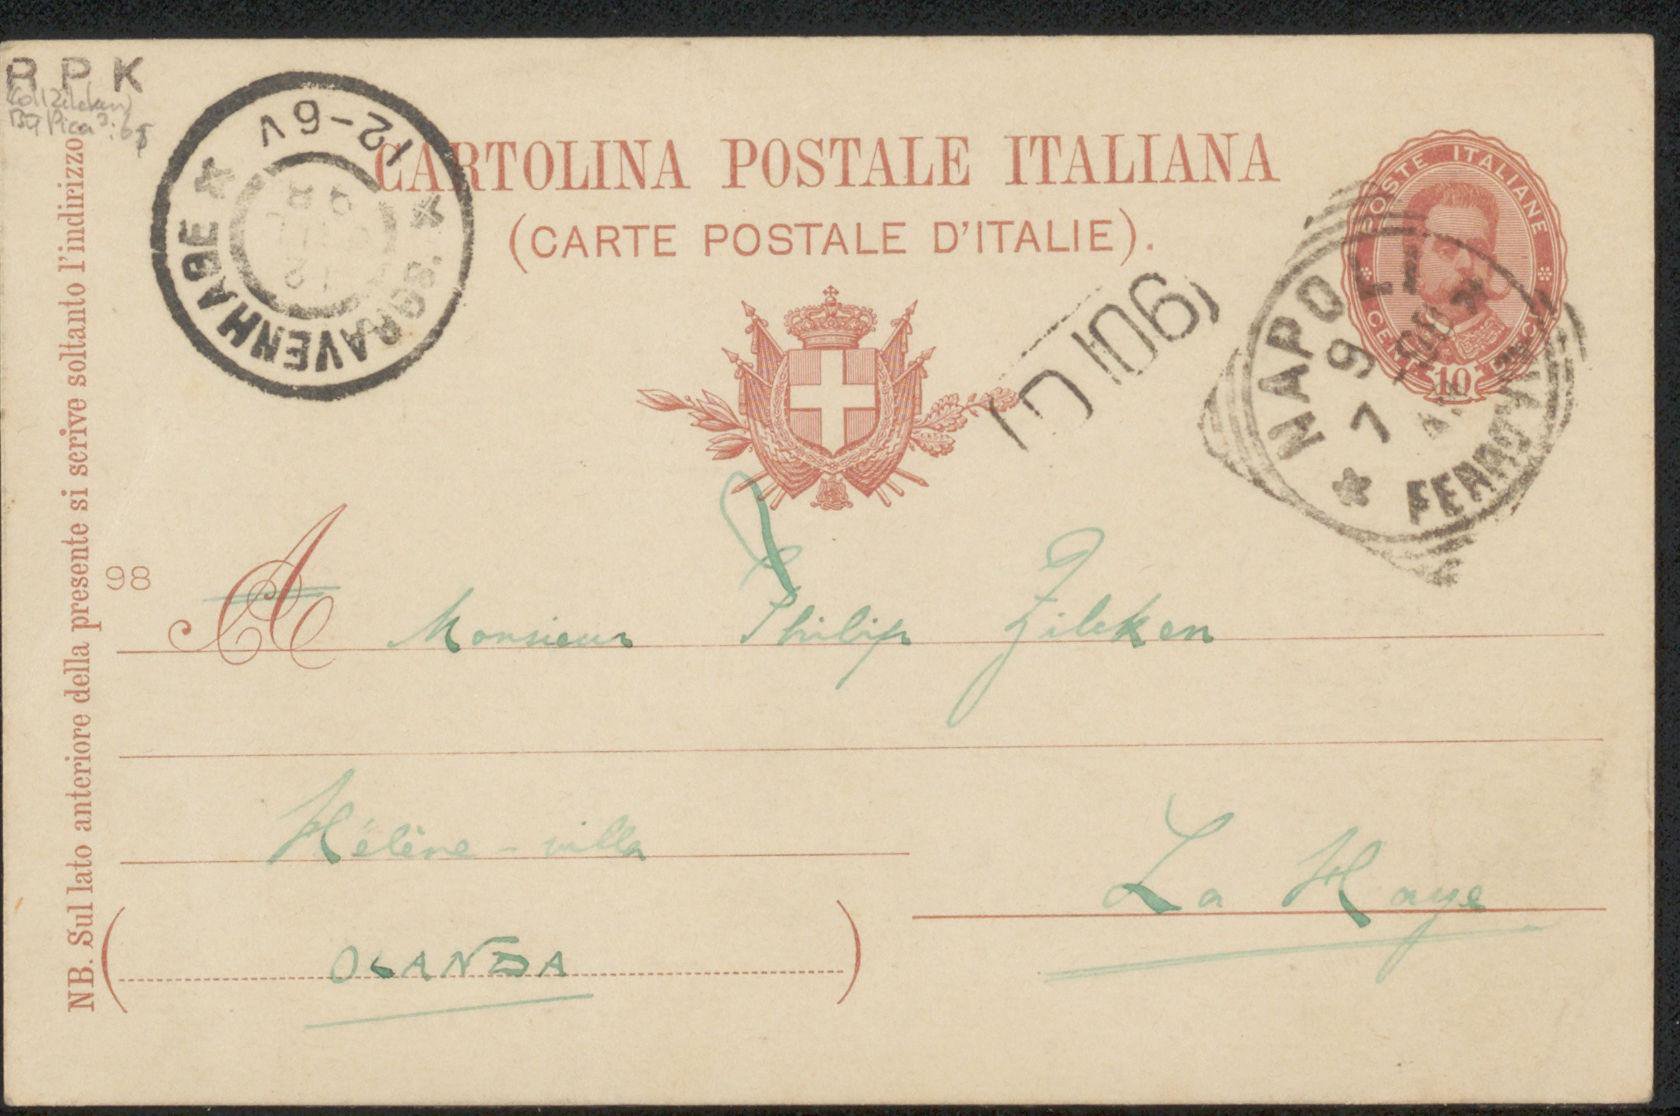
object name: postcard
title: Briefkaart aan Philip Zilcken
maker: vittorio pica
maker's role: criticus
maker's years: 1864-1930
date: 1898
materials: cardboard, ink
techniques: pen, writing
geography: naples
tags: carel nicolaas storm van 's-gravesande, amsterdam, painter, print maker, draughtsman, willem witsen, jan toorop, baronne madeleine deslandes, philip zilcken, the graphic arts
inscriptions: collector's mark: ‘RPK’